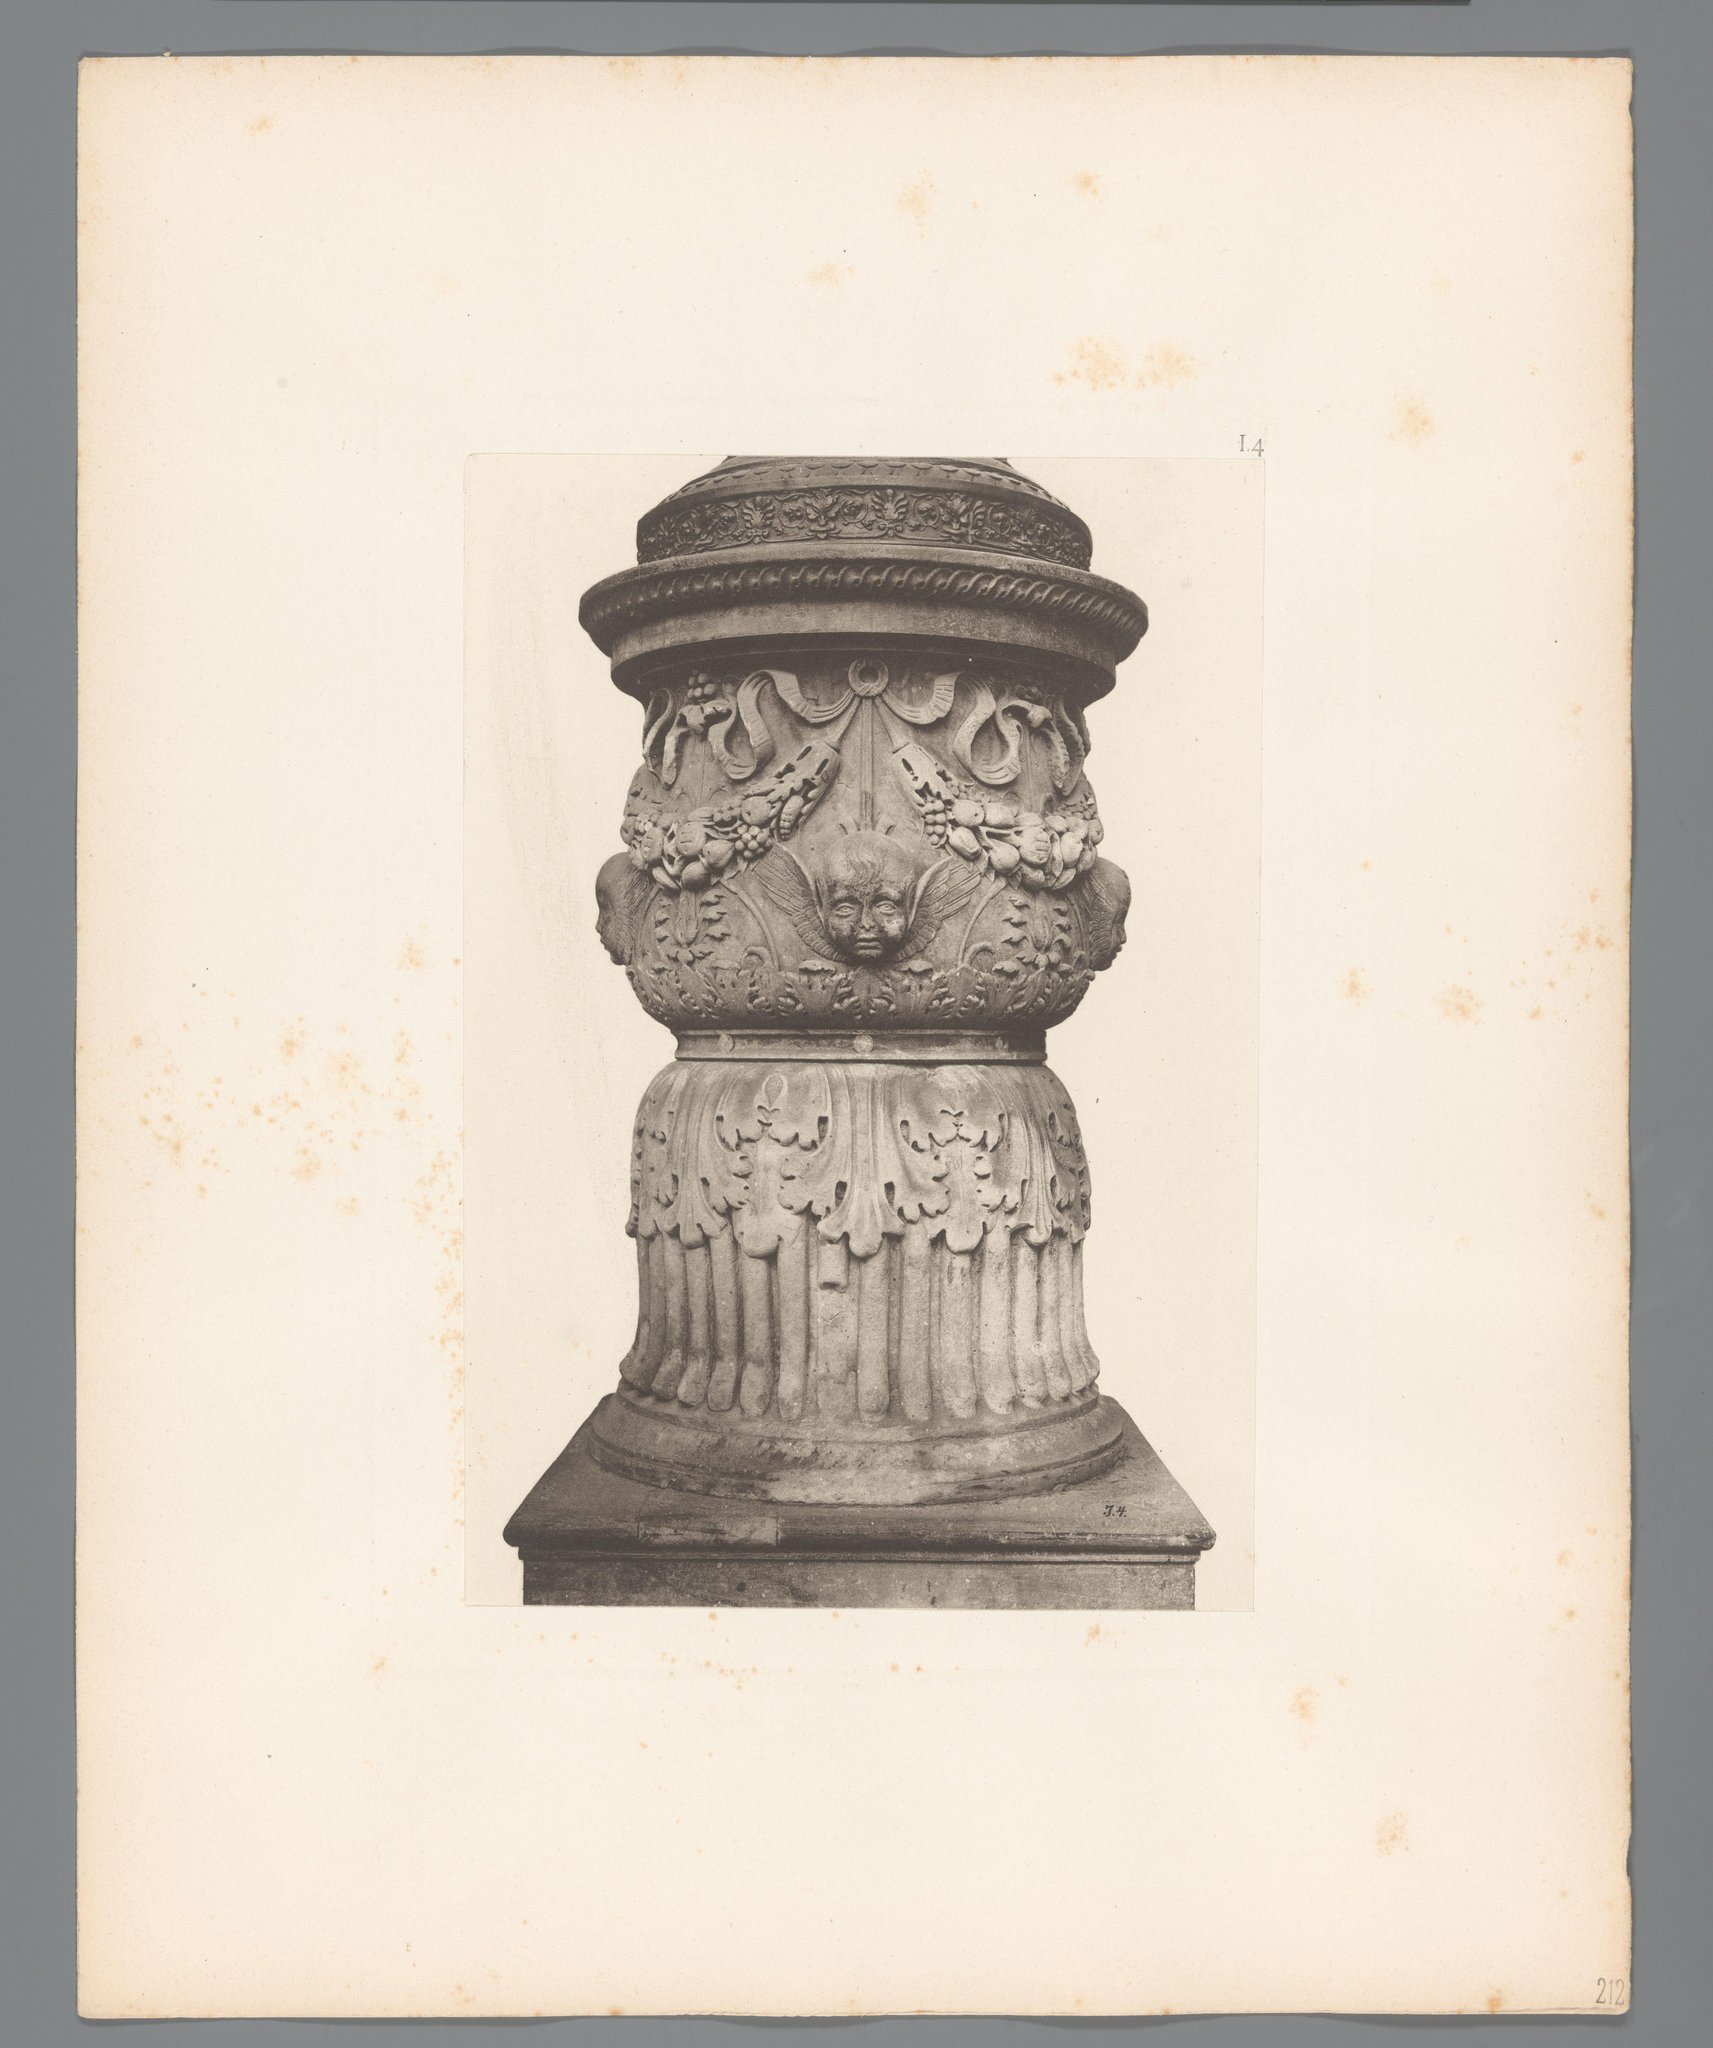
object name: photomechanical print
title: Deel van een zuil met een gezicht van een engel, van de San Marco in Venetië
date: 1880-1885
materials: paper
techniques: photograph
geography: st. mark's basilica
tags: column, pillar ~ architecture, angels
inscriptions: number: ‘J.4.’, number: ‘I.4’, number: ‘212’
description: Deze prent maakt deel uit van een omslag met 79 prenten op 53 bladen en 2 tekstbladen.